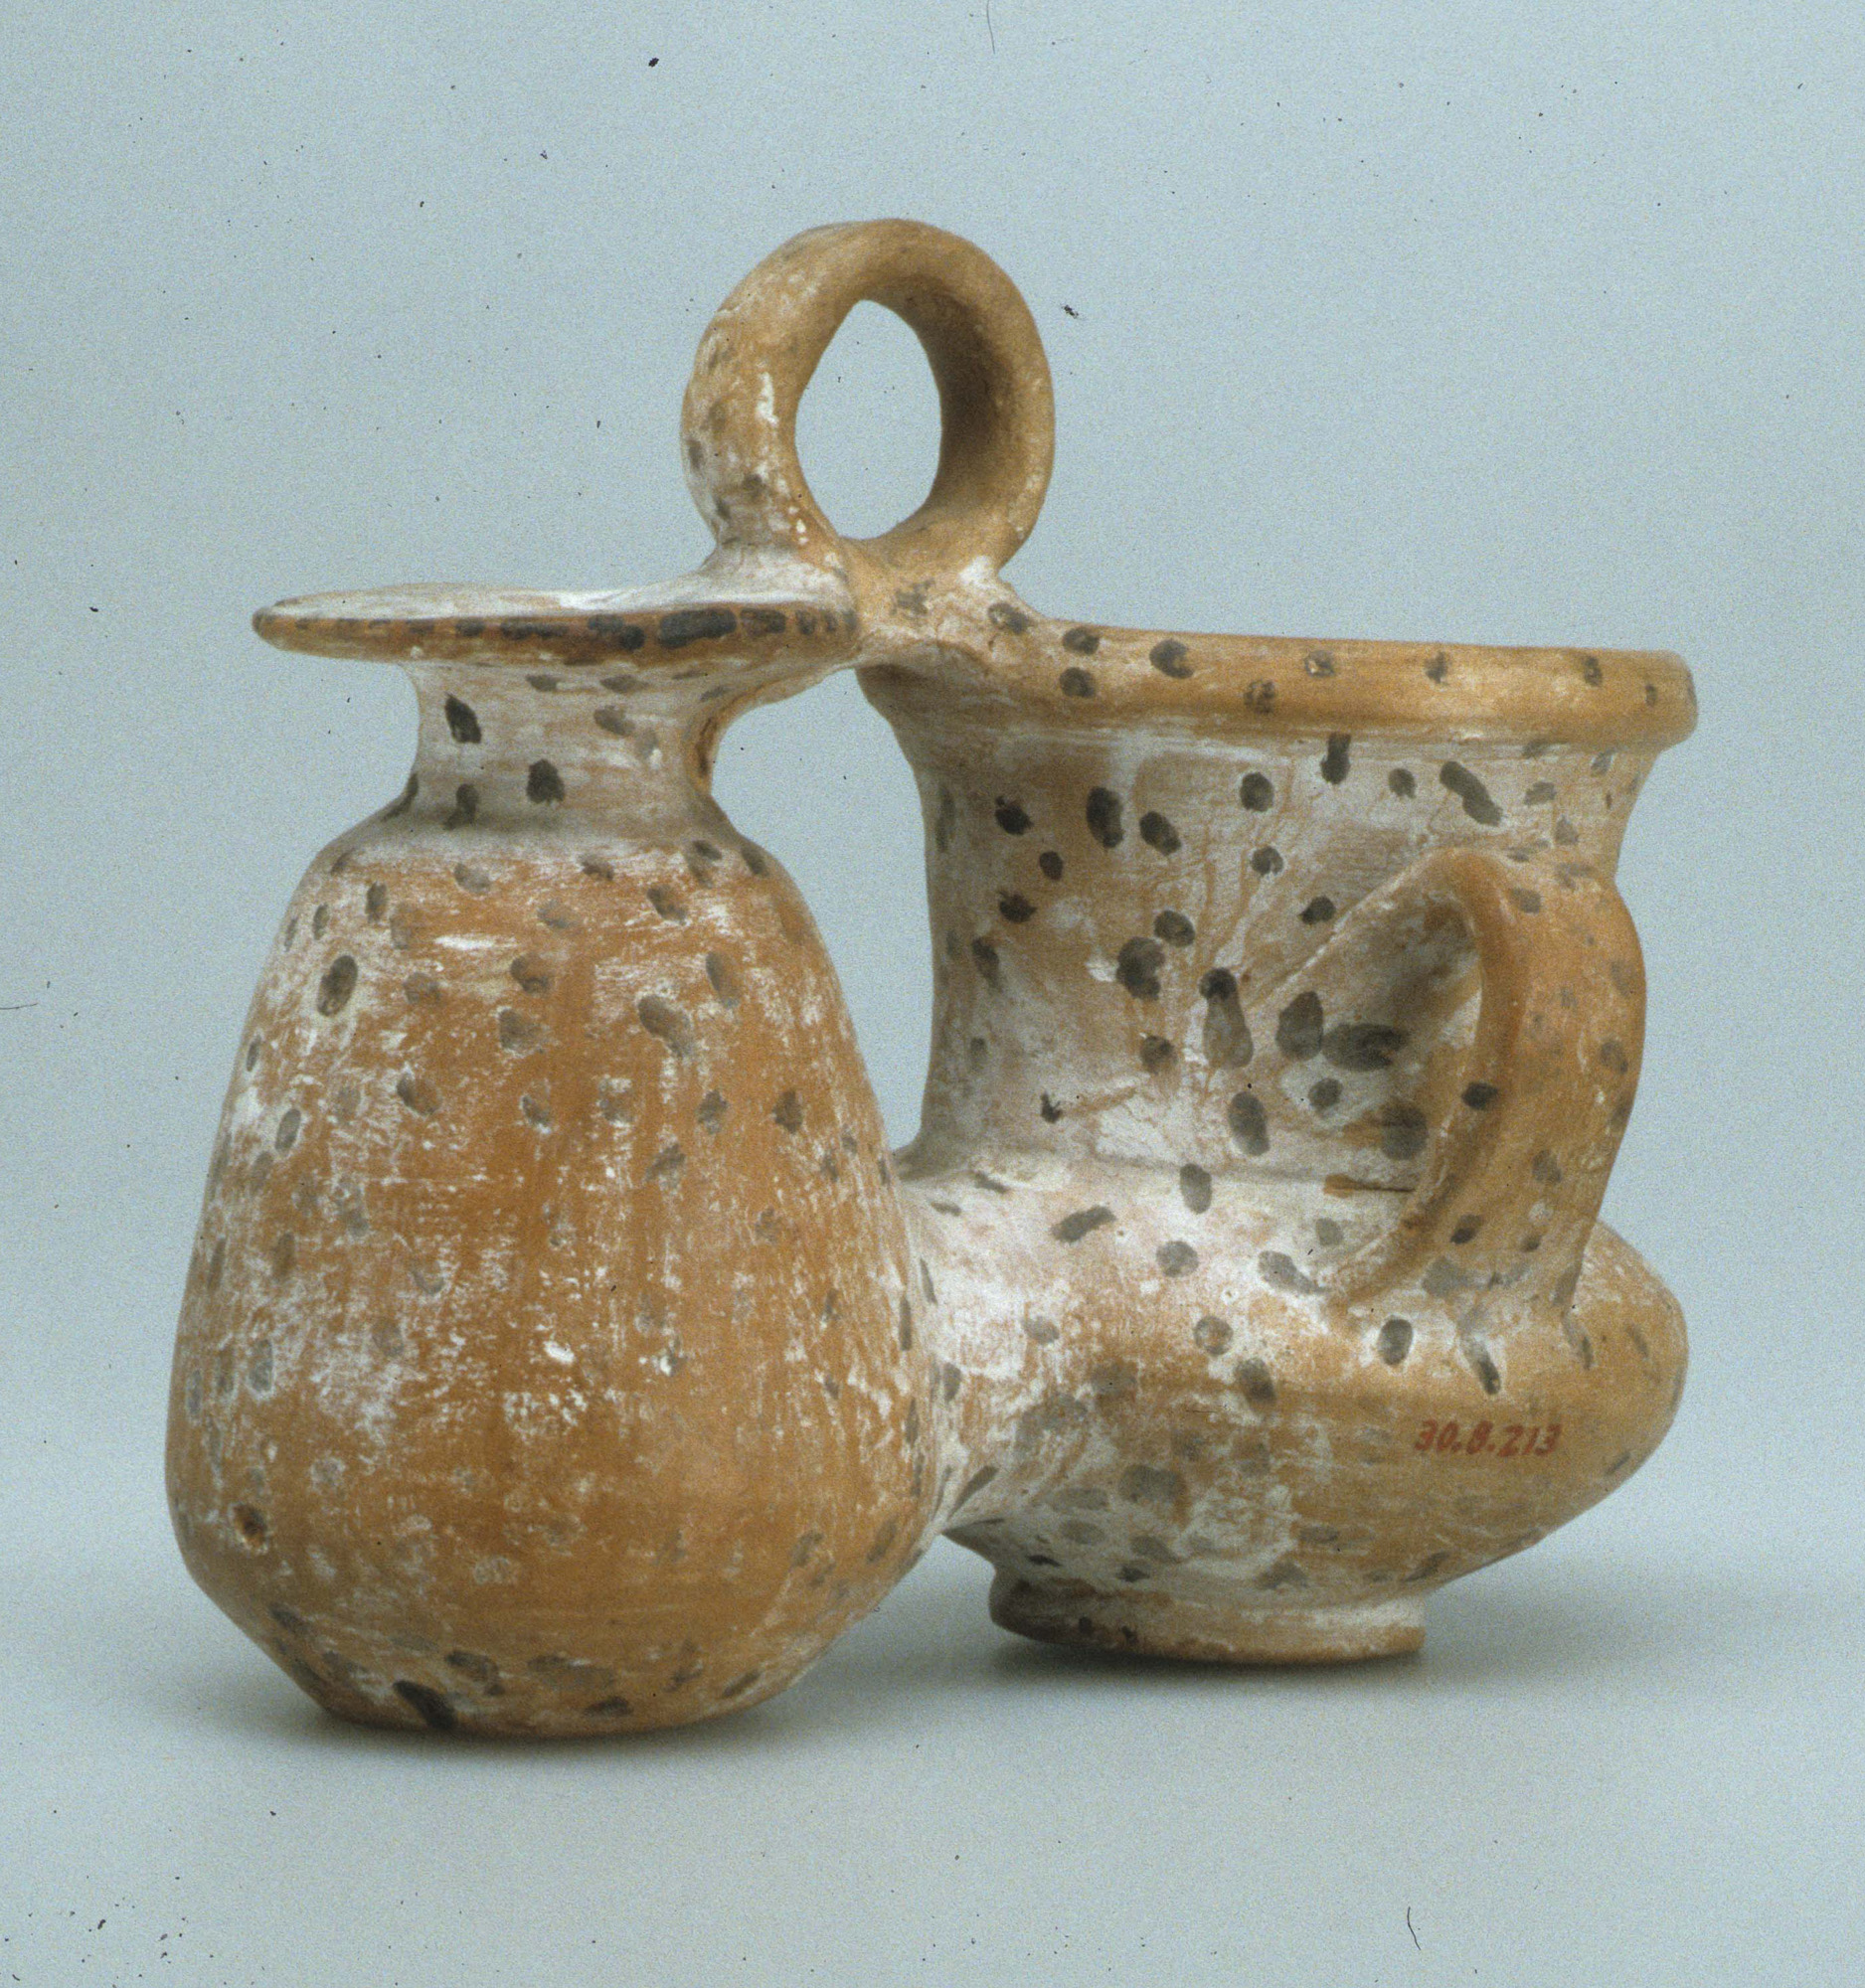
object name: jar, double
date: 1550-1295 BCE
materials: pottery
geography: egypt